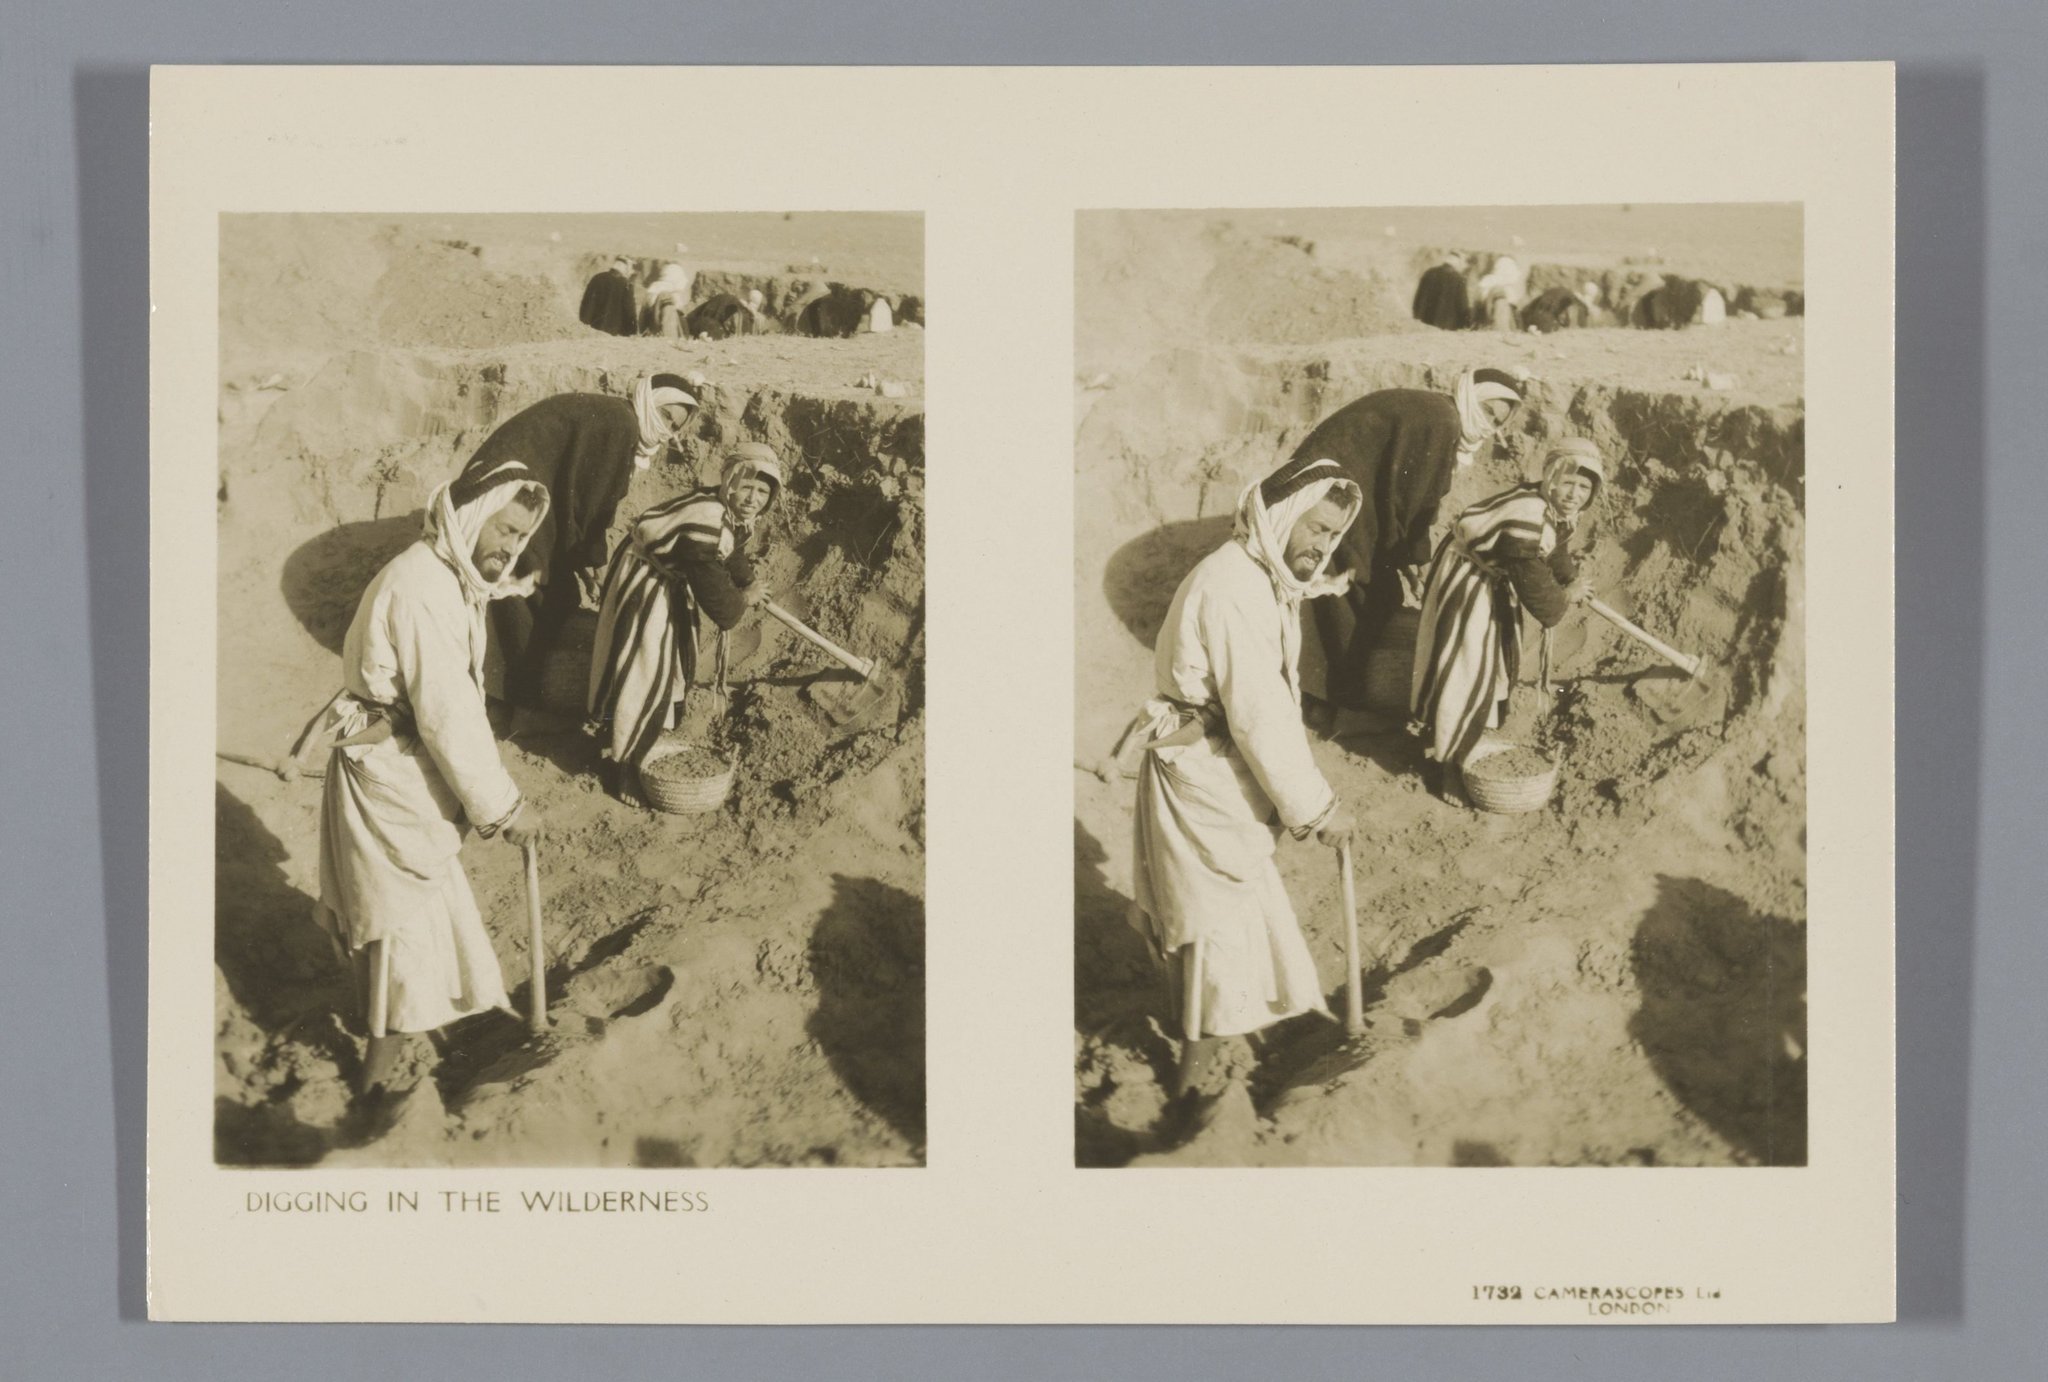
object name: stereograph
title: Mannen bij een opgraving in de woestijn, nabij Tell Fara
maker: richard st. barbe baker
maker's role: activist, bioloog, botanicus, fotograaf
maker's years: 1889-1982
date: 1902-1929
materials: paper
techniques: gelatin silver print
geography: birmingham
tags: excavation ~ archaeology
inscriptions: number: ‘1732’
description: Serie over de opgravingen van de Britse archeologen Gerald Harding en Flinders Petrie bij Tell Fara in het toenmalige Brits Mandaatgebied Palestina.